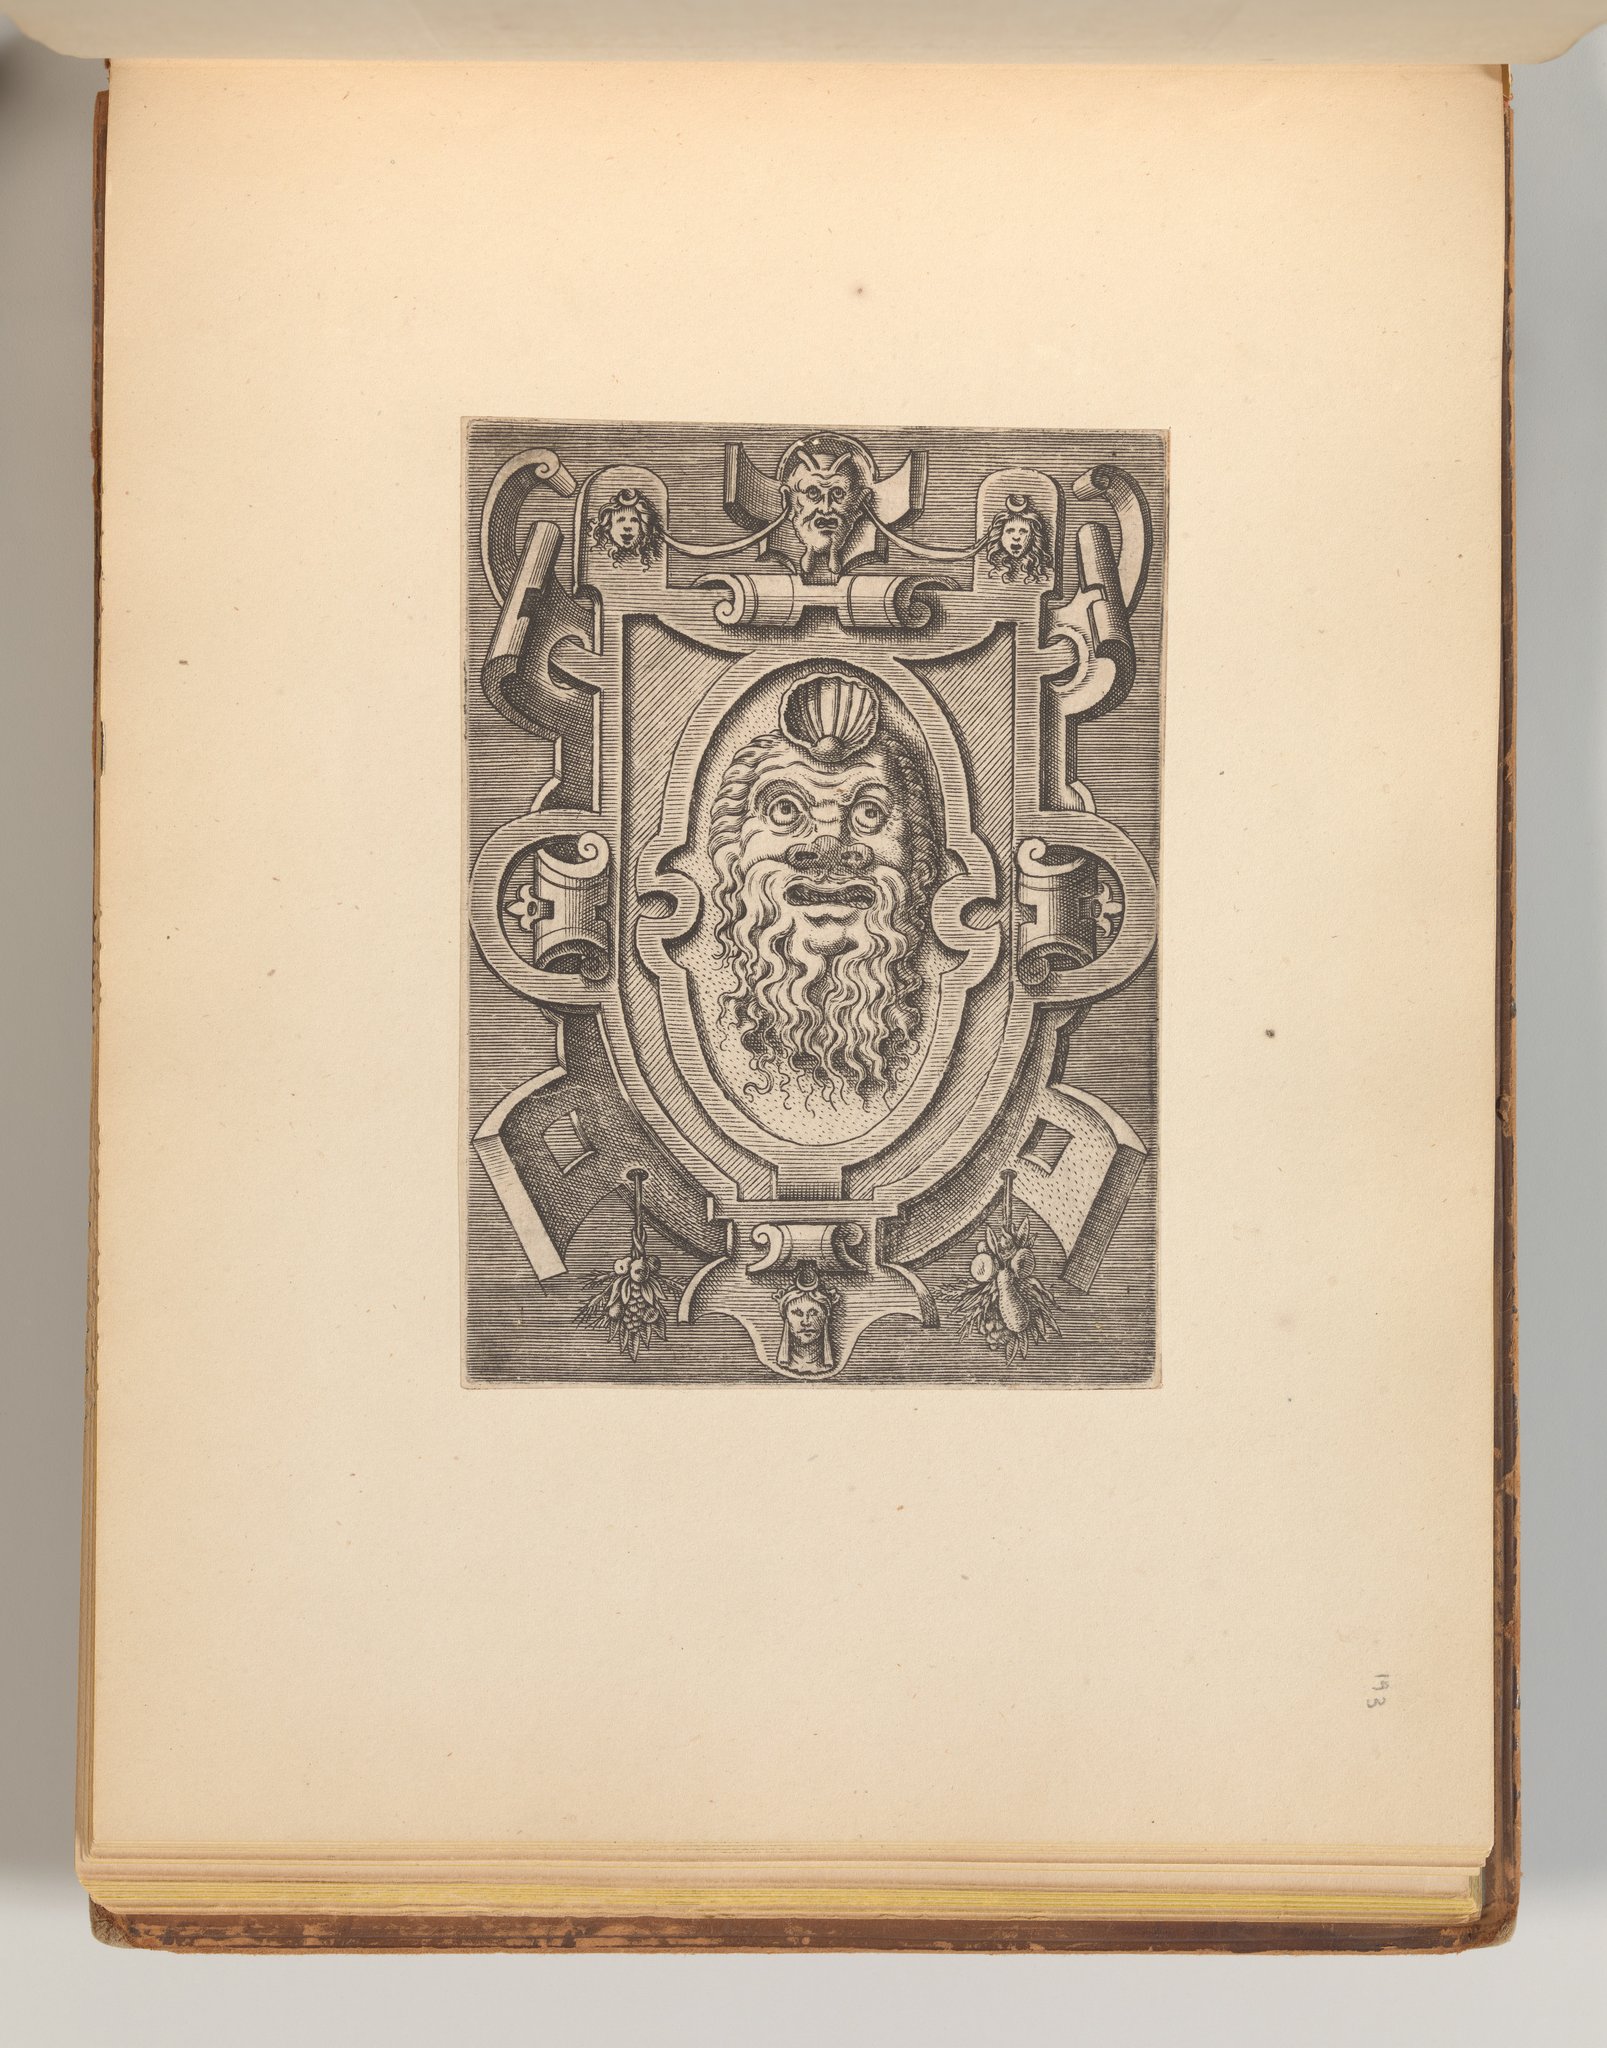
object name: album print ornament architecture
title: Series of Cartouches, in: Targhe ed altri ornati di varie e capricciose invenzioni (Cartouches and other ornaments of various and capricious invention, page 35)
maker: cornelis bos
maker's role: artist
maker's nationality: netherlandish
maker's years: 1510-1556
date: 1545-1560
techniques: engraving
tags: masks,cartouches,ornament